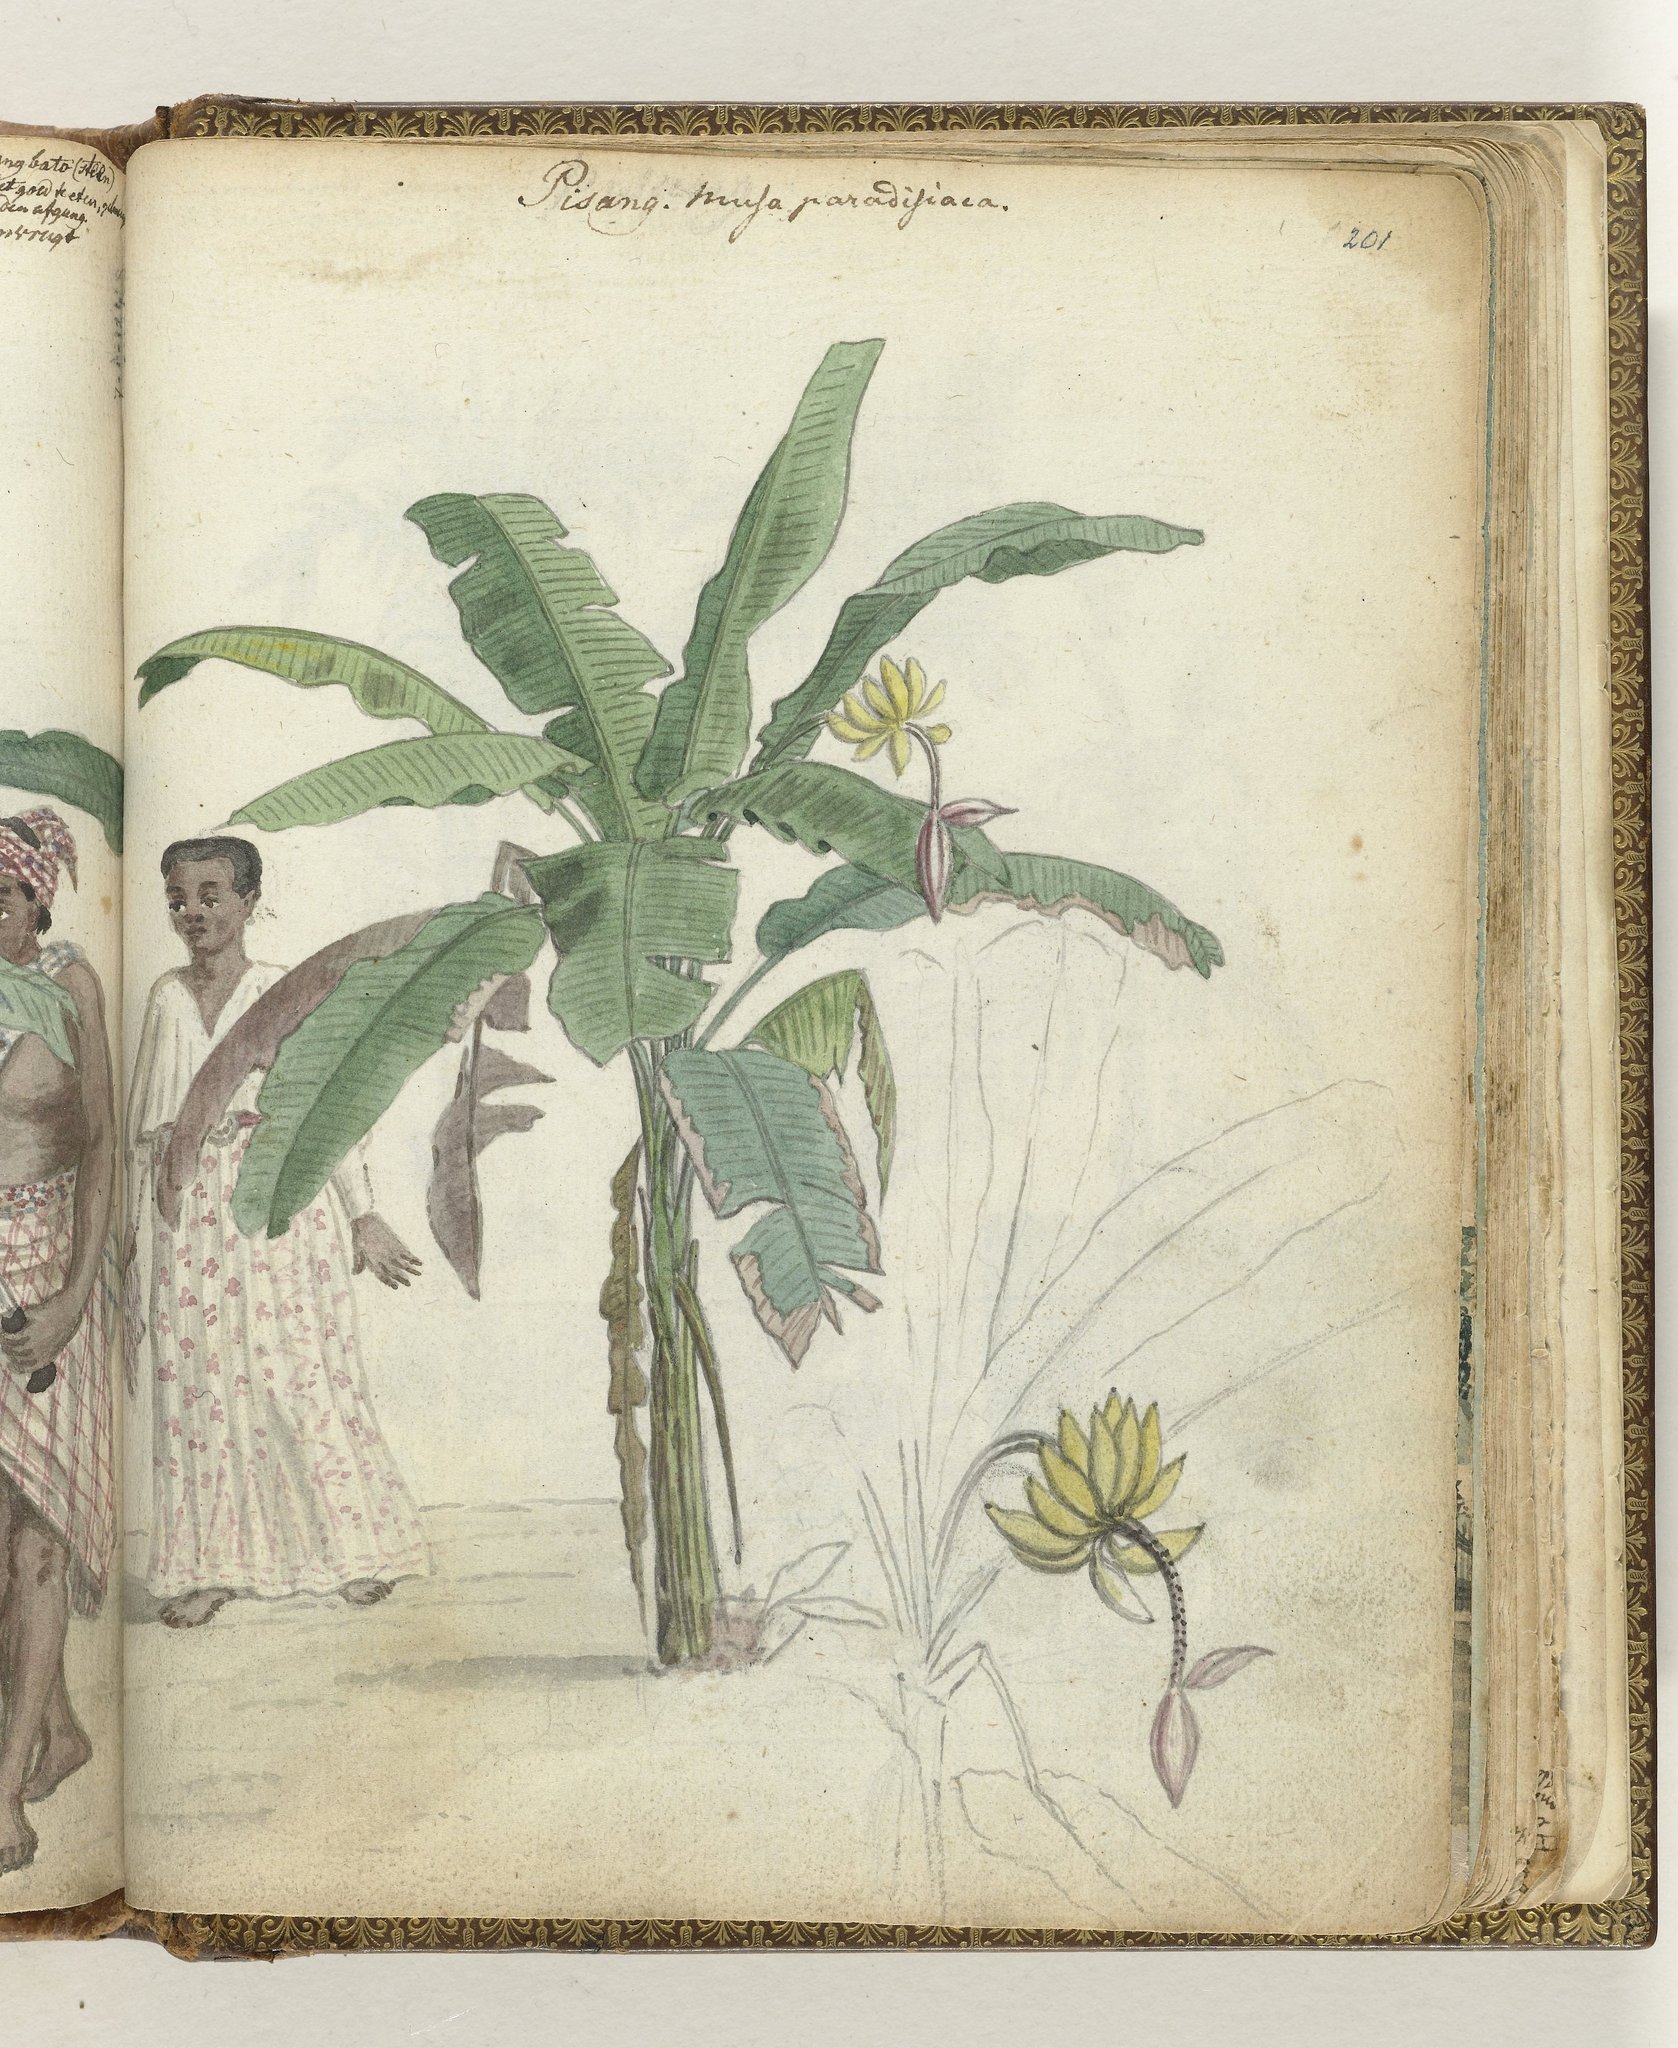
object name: drawing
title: Pisangboom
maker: jan brandes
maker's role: draughtsman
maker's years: 1743-1808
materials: paper, pencil, watercolor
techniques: brush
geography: jakarta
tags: fruits: banana, indonesia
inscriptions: inscription: ‘Pisang musa paradisiaca.’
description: Kleurtekening van een pisang - of bananenboom en een Indonesische vrouw. Met opschrift. Onderdeel uit het schetsboek van Jan Brandes, dl. 1 (1808), p. 200-201.